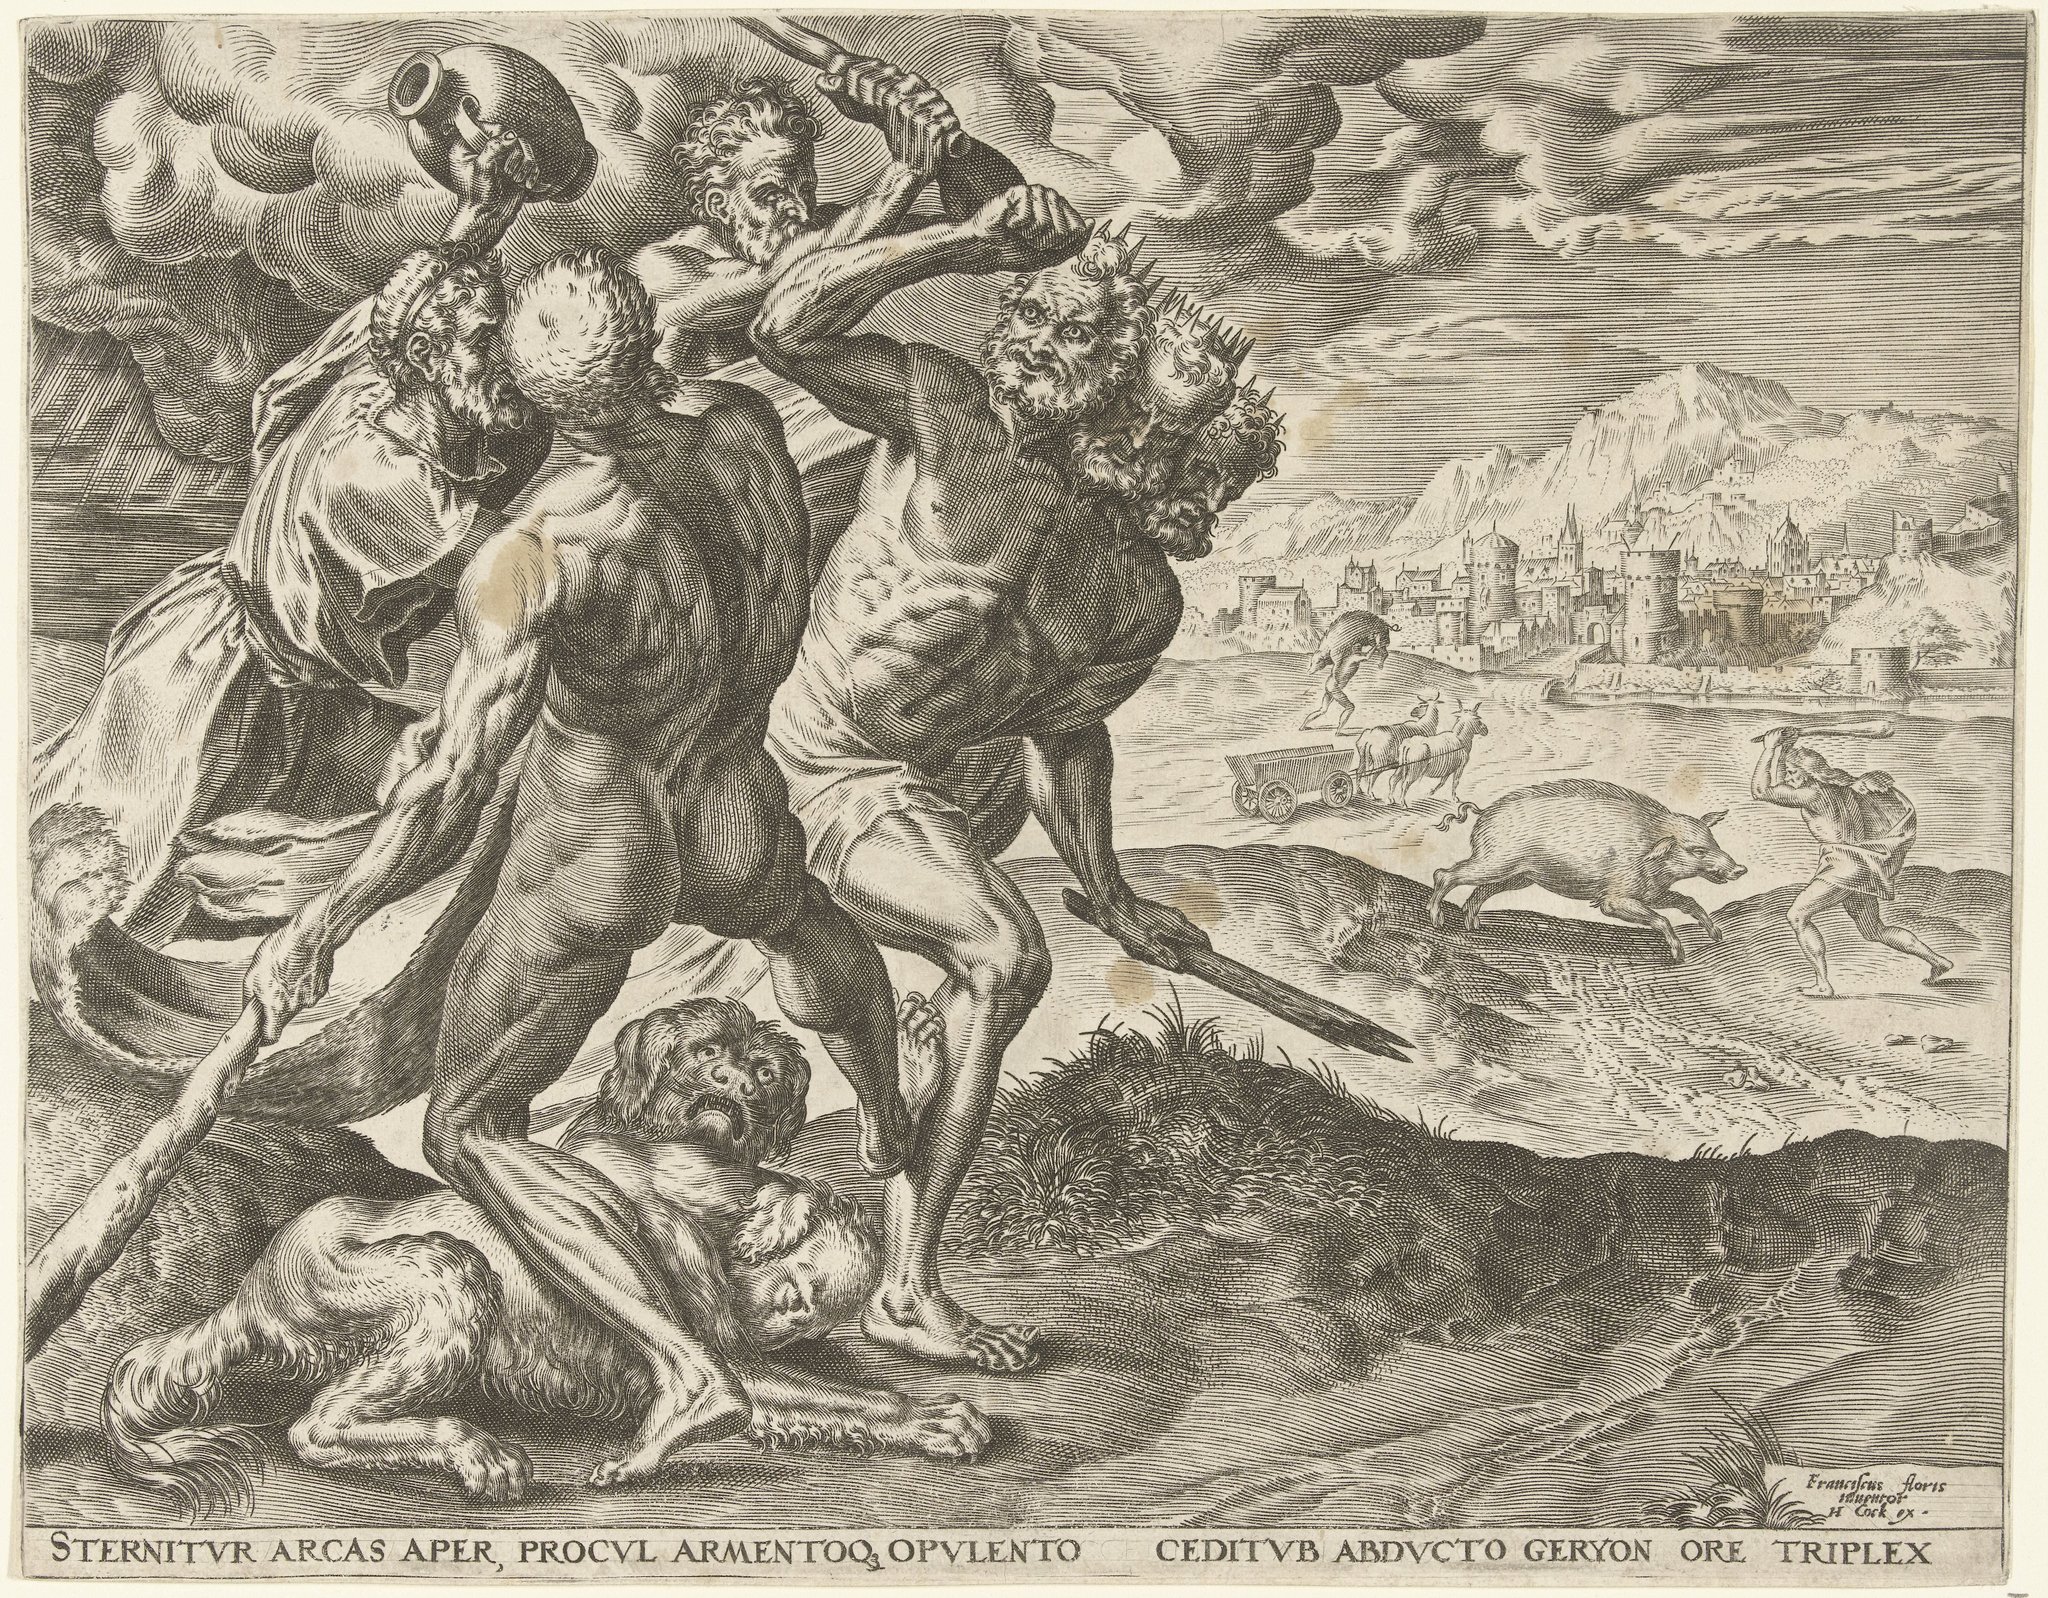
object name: print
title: Werken van Hercules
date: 1563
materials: paper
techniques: engraving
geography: antwerp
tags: (4) the erymanthian boar is captured by hercules, hercules kills geryon, the monster with three heads and three bodies, after having slain the herdsman eurytion, and orthrus, the two-headed watch-dog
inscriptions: collector's mark: Lugt 2228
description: Hercules verslaat de driekoppige reus Geryon en zijn tweekoppige hond. Op de achtergrond is te zien hoe Hercules het zwijn van Erymanthus vangt en naar de stad brengt.